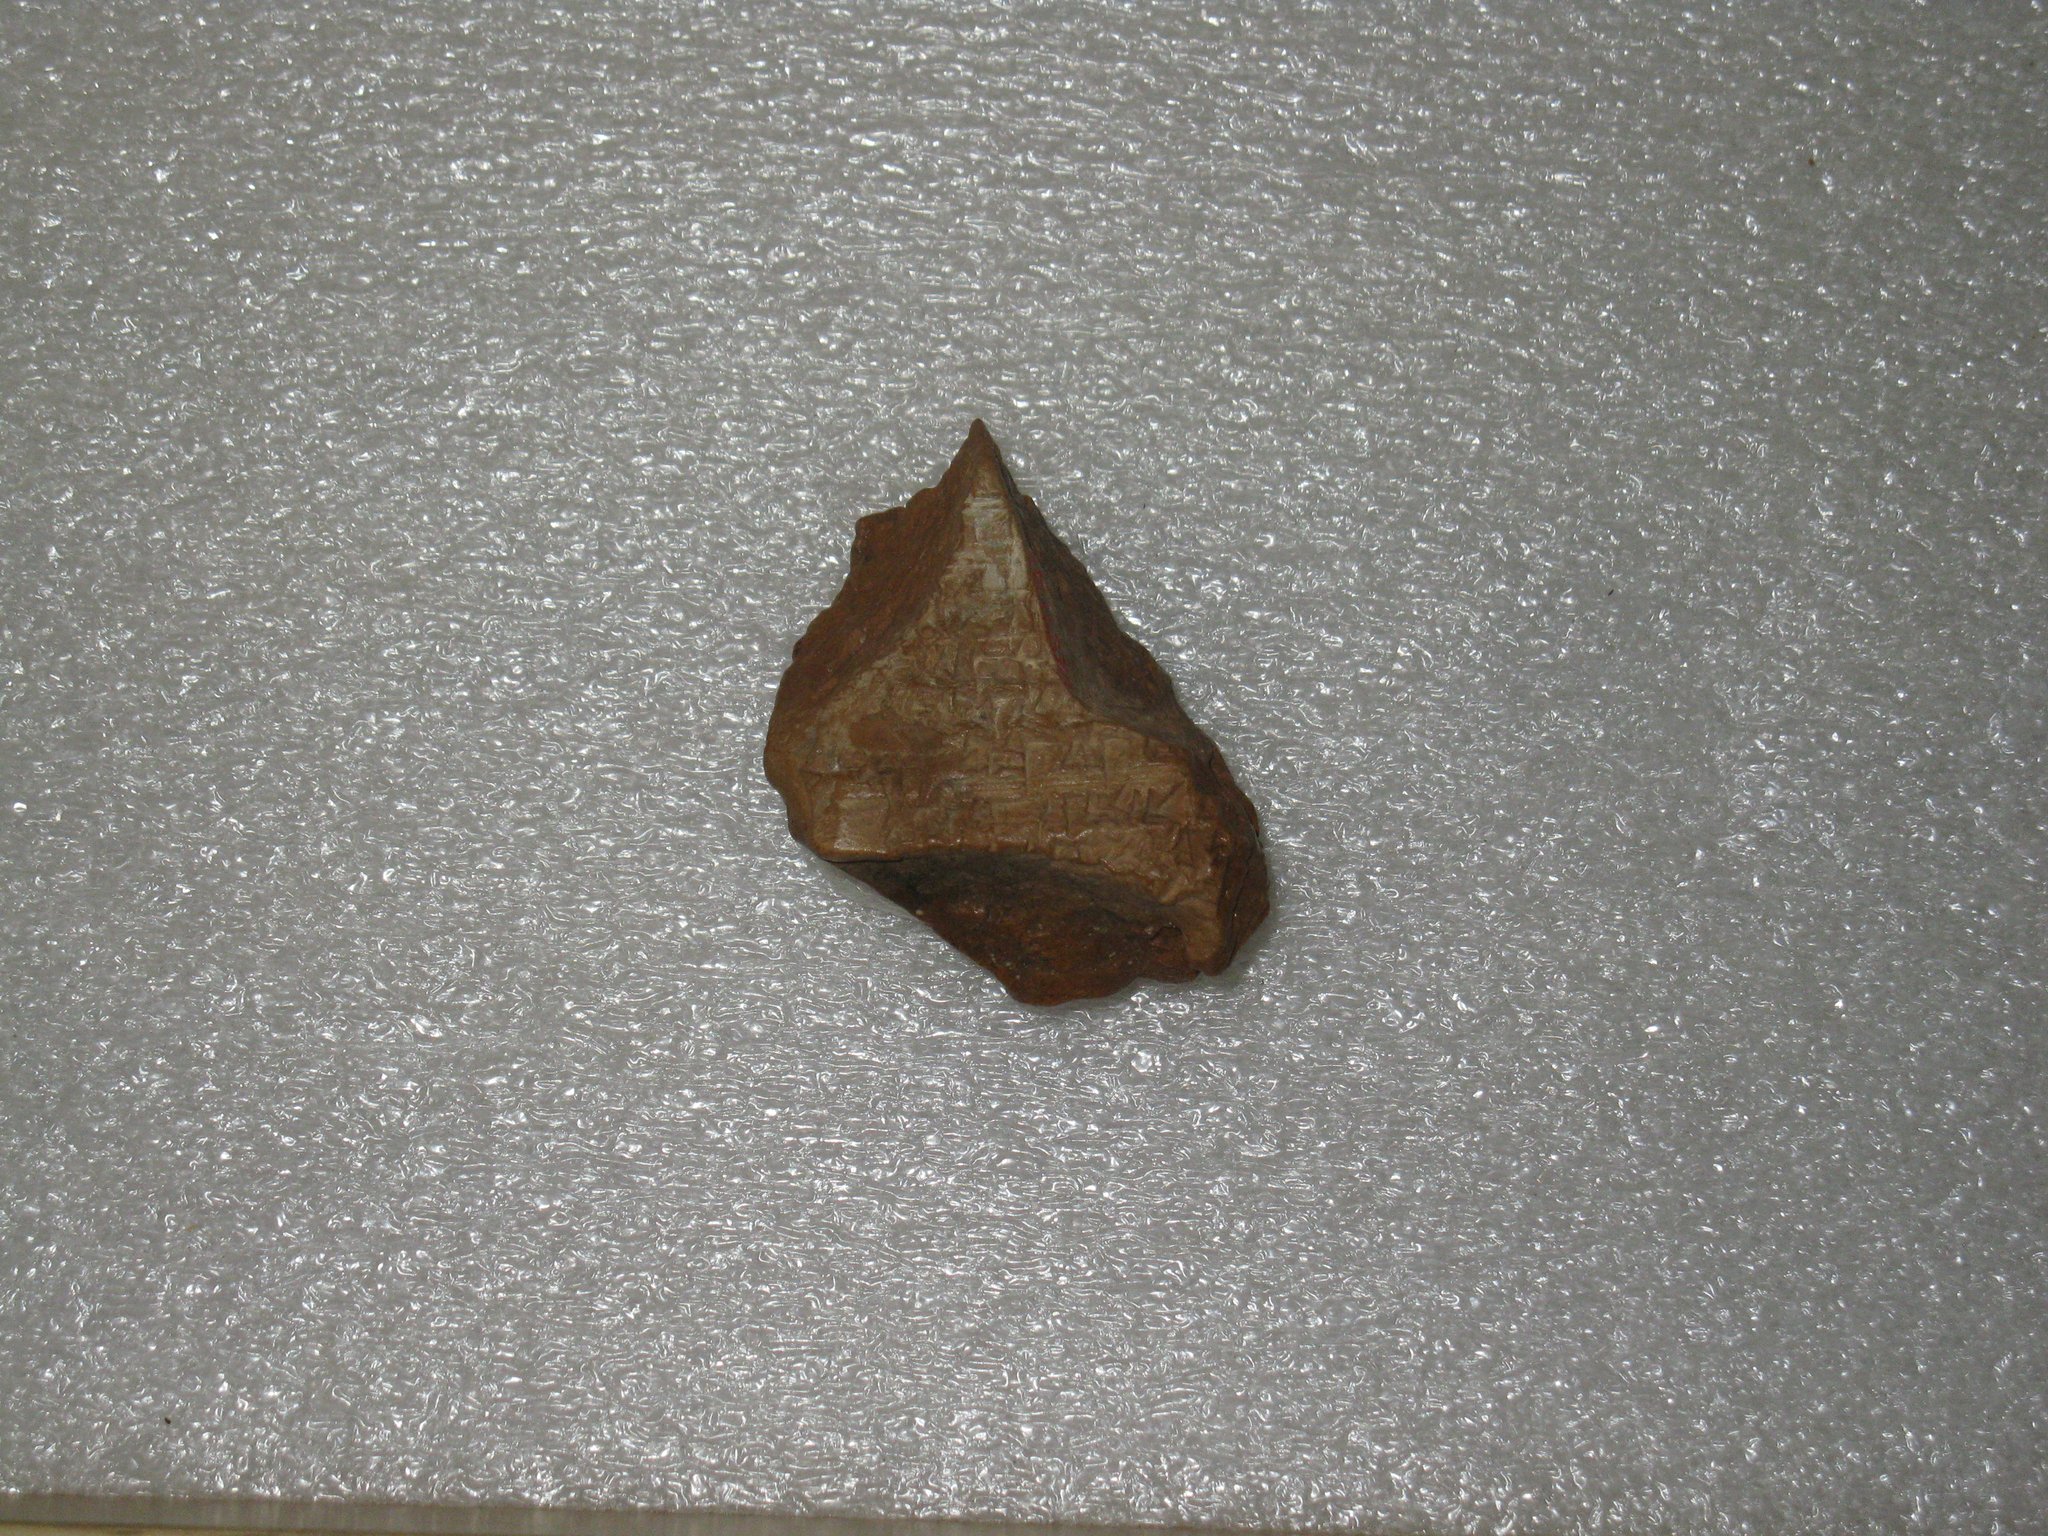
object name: cuneiform tablet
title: Cuneiform tablet: unidentified fragment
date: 333-1 BCE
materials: clay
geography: mesopotamia